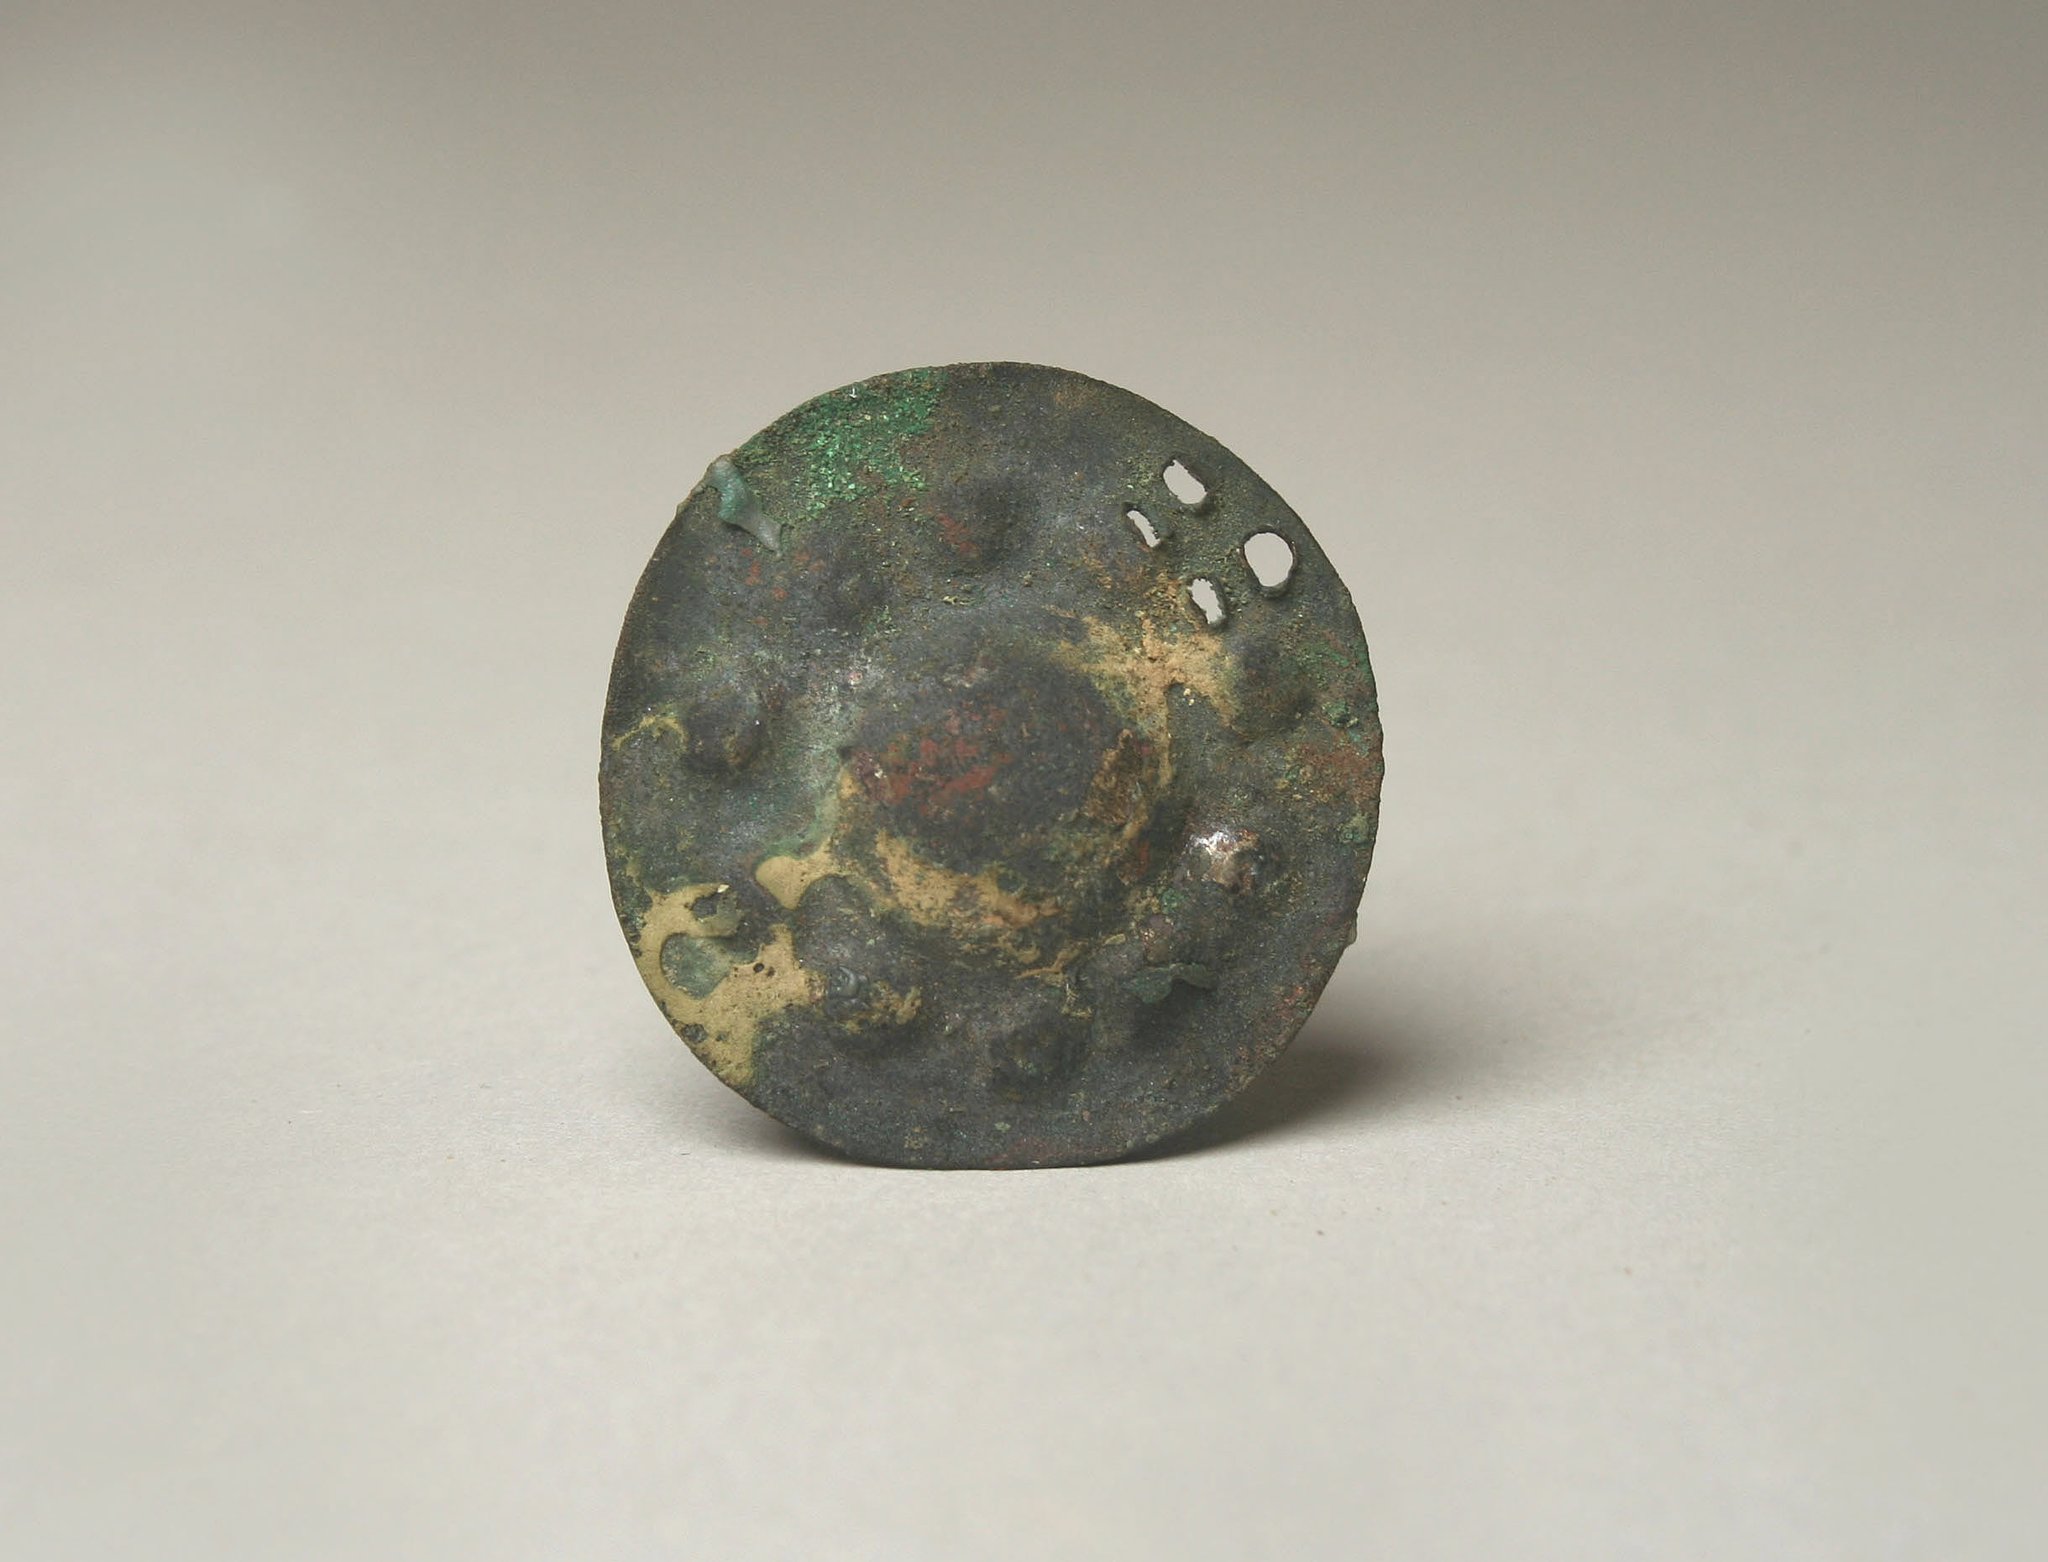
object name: ornament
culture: moche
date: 501-700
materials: metal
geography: peru